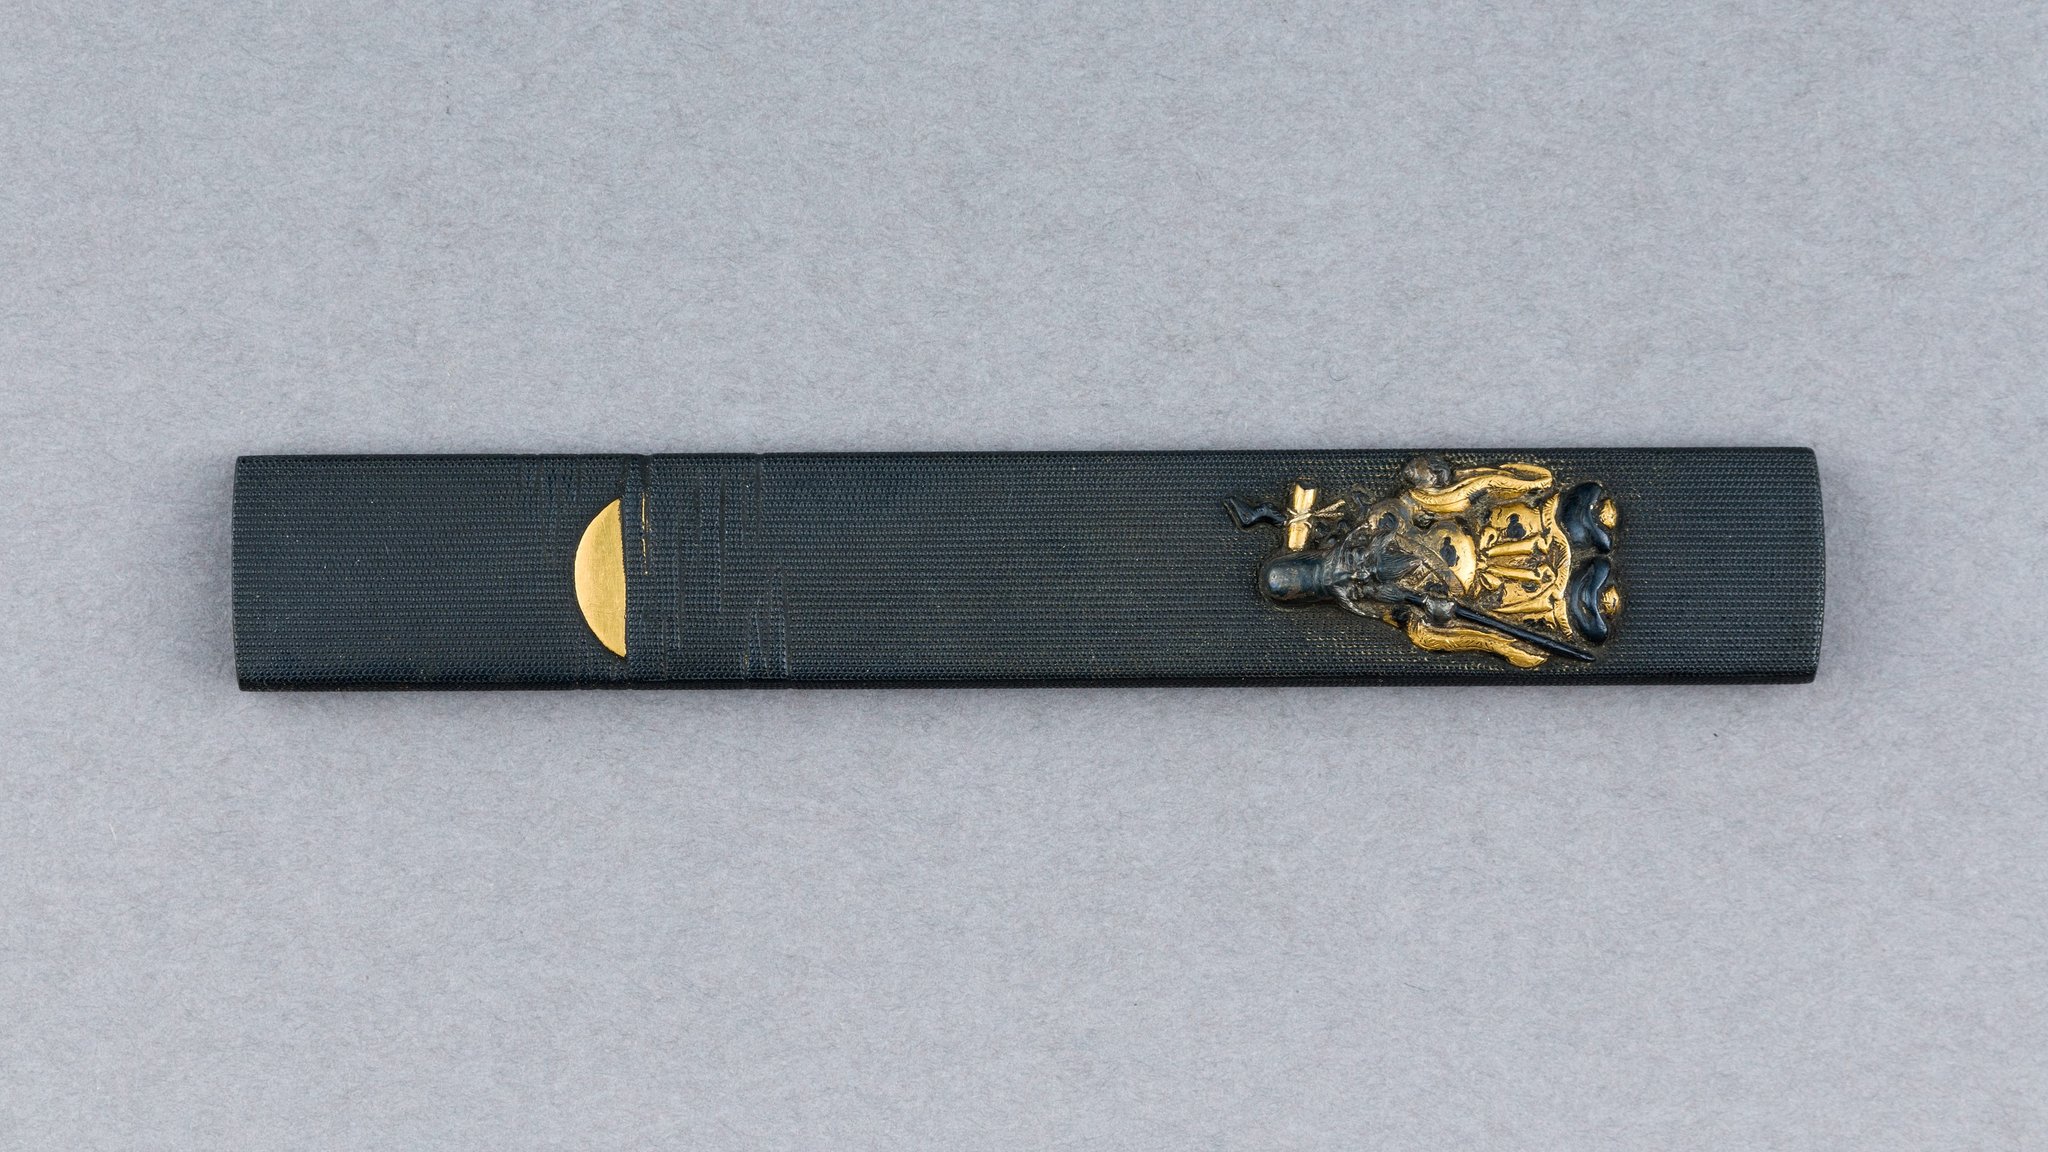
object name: knife handle kozuka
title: Knife Handle (Kozuka)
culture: japanese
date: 1615-1868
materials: gold alloy, gold, silver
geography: japan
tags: men